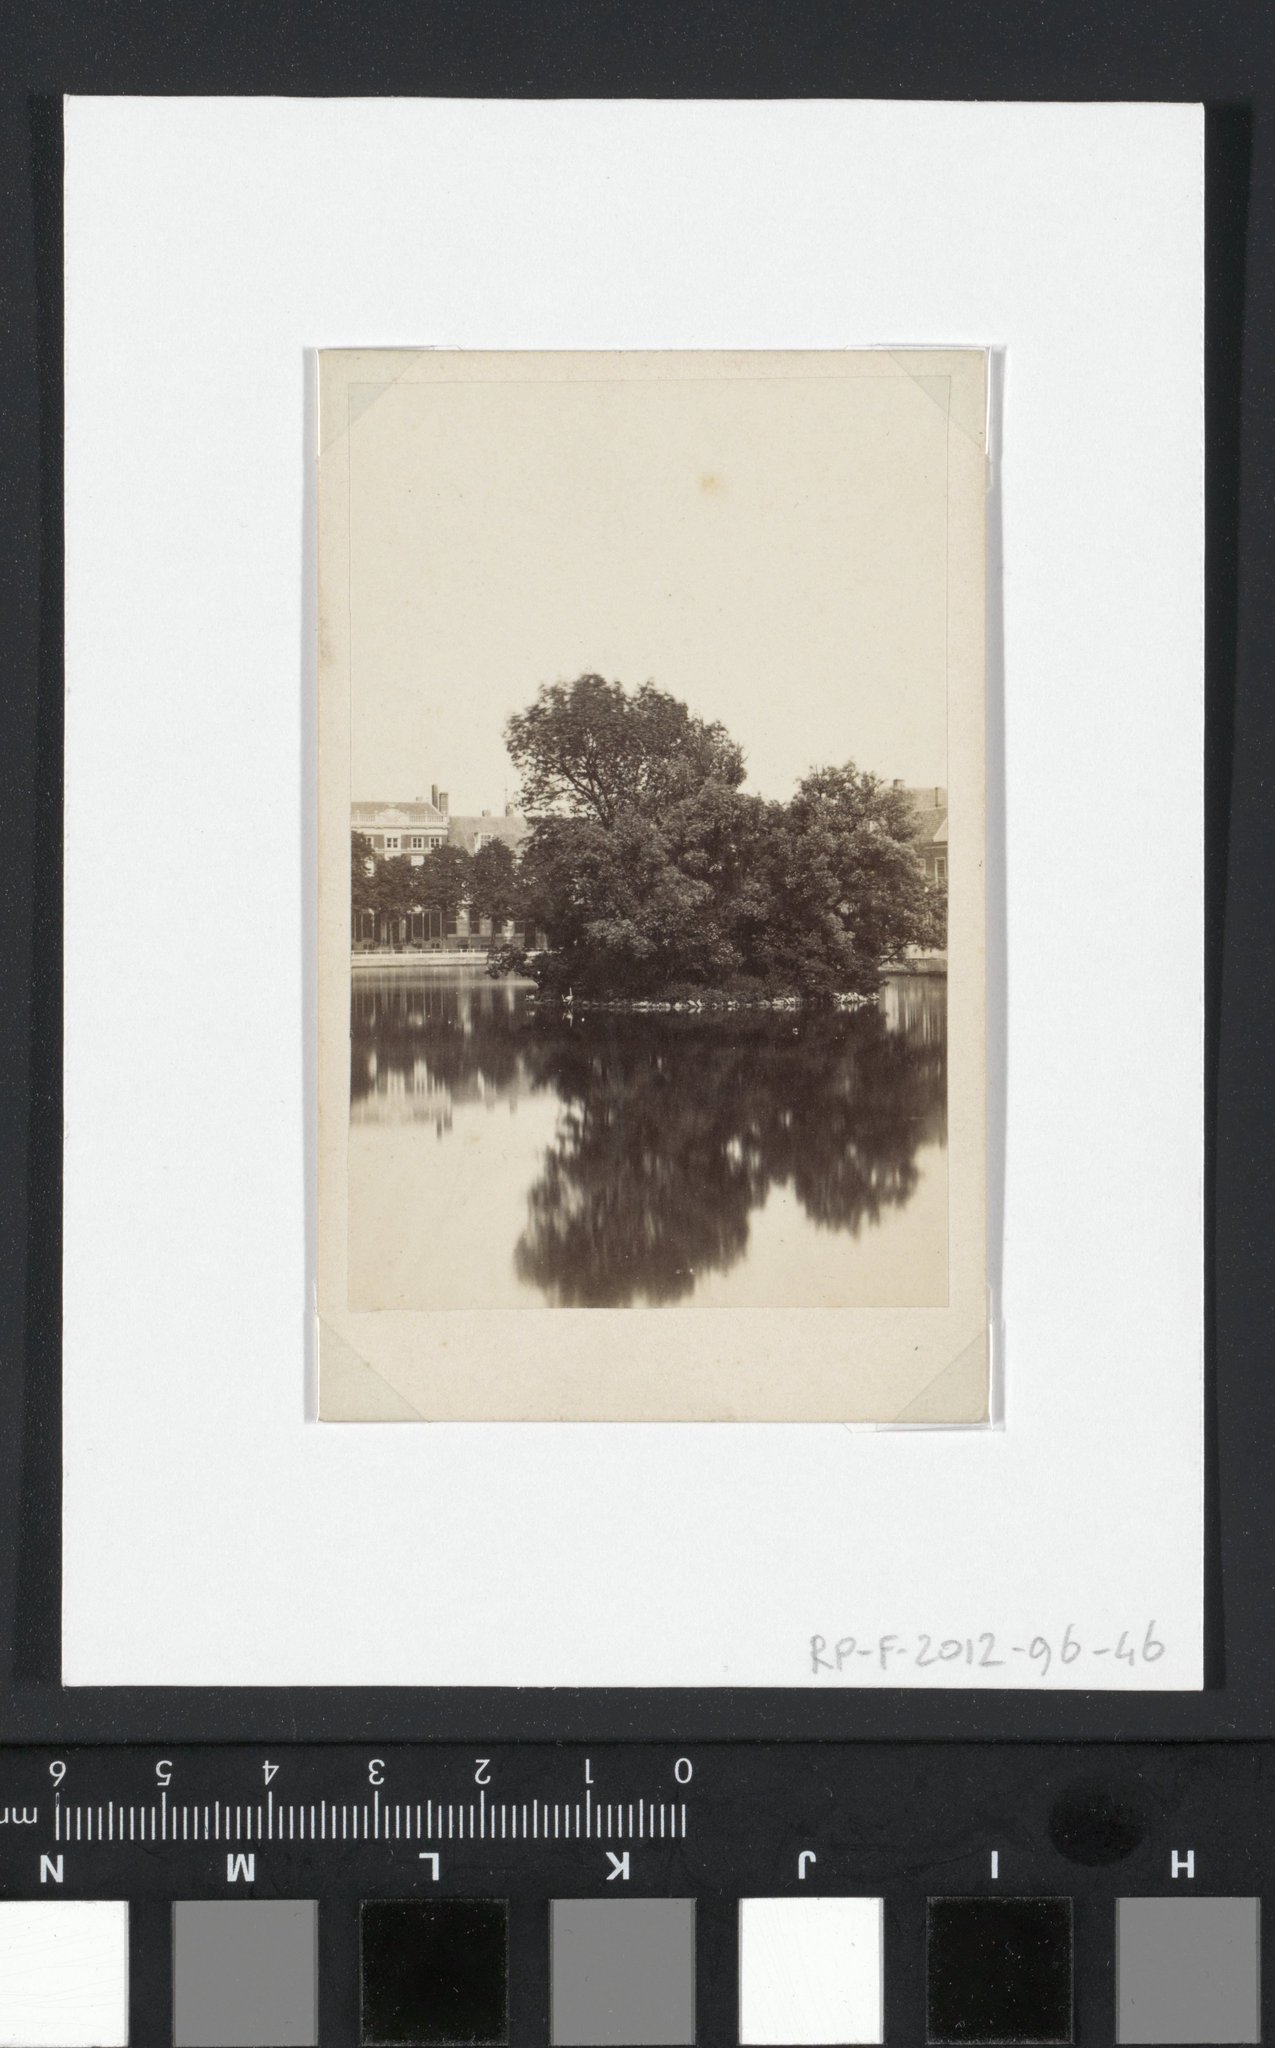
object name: photograph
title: Gezicht op de Hofvijver in Den Haag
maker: Anonymous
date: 1860-1880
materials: cardboard, paper, photographic support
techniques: albumen print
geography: the hague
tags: pond